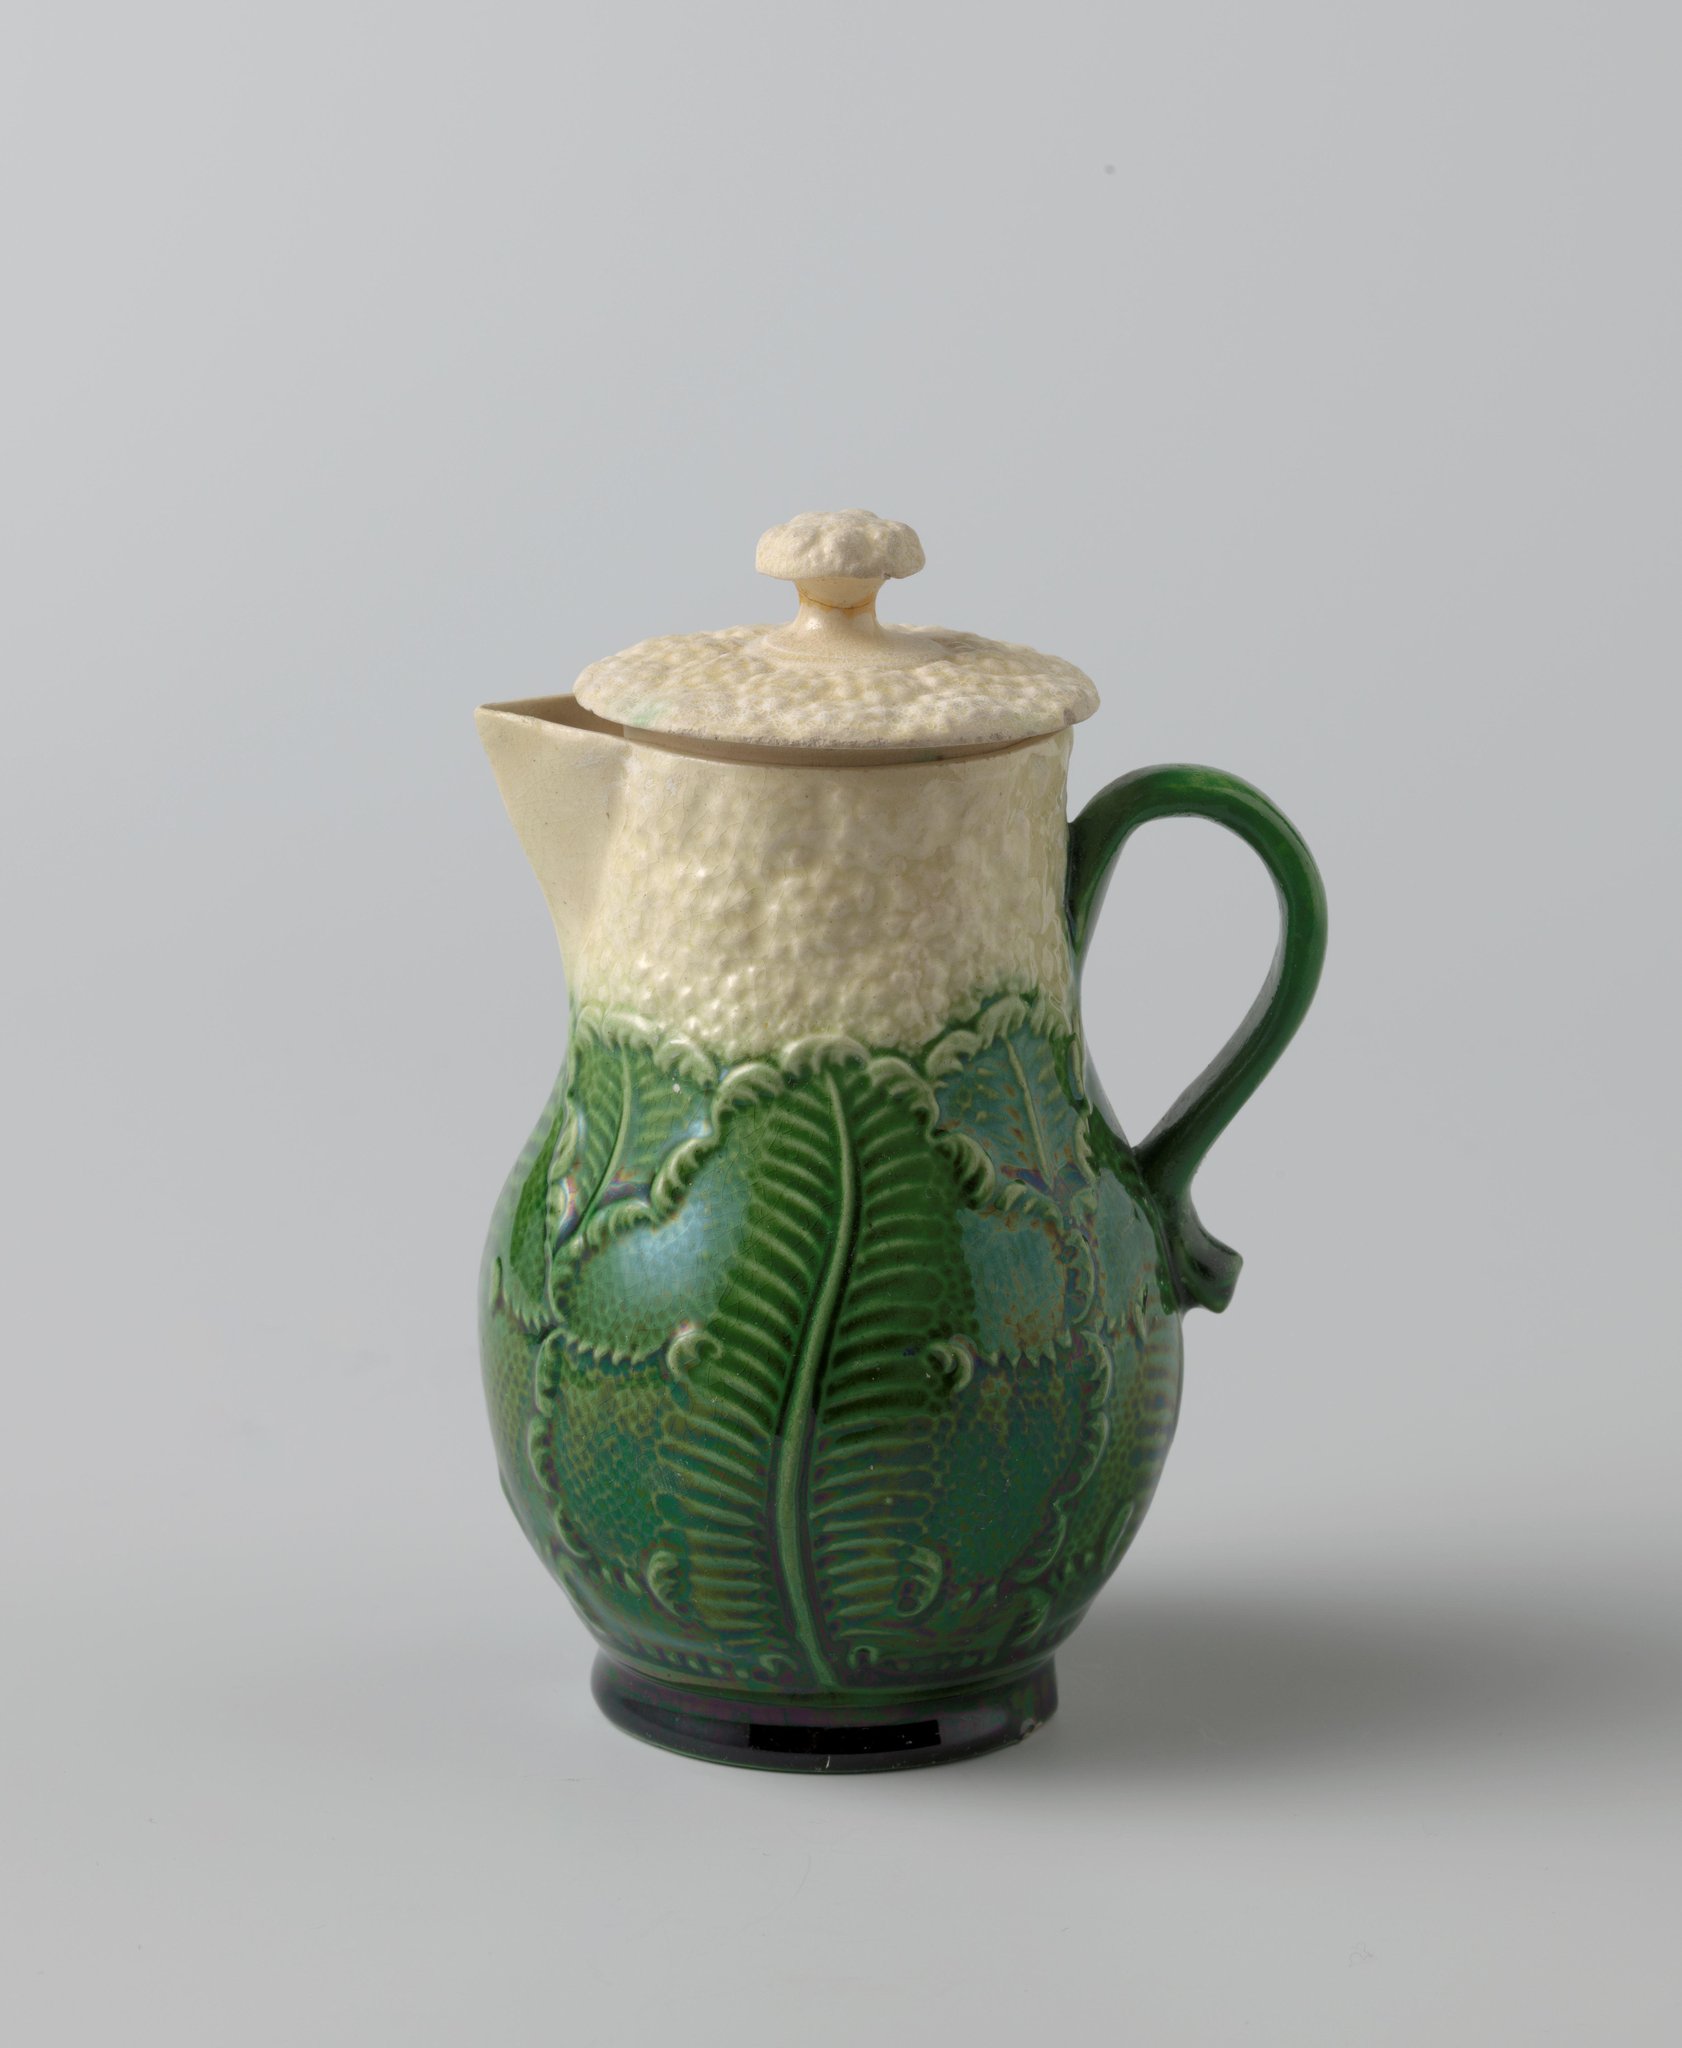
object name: ewer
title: Deksel van hardgebakken aardewerk; Whieldon ware, cauliflower ware.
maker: Anonymous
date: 1765-1775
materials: earthenware, glaze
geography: england